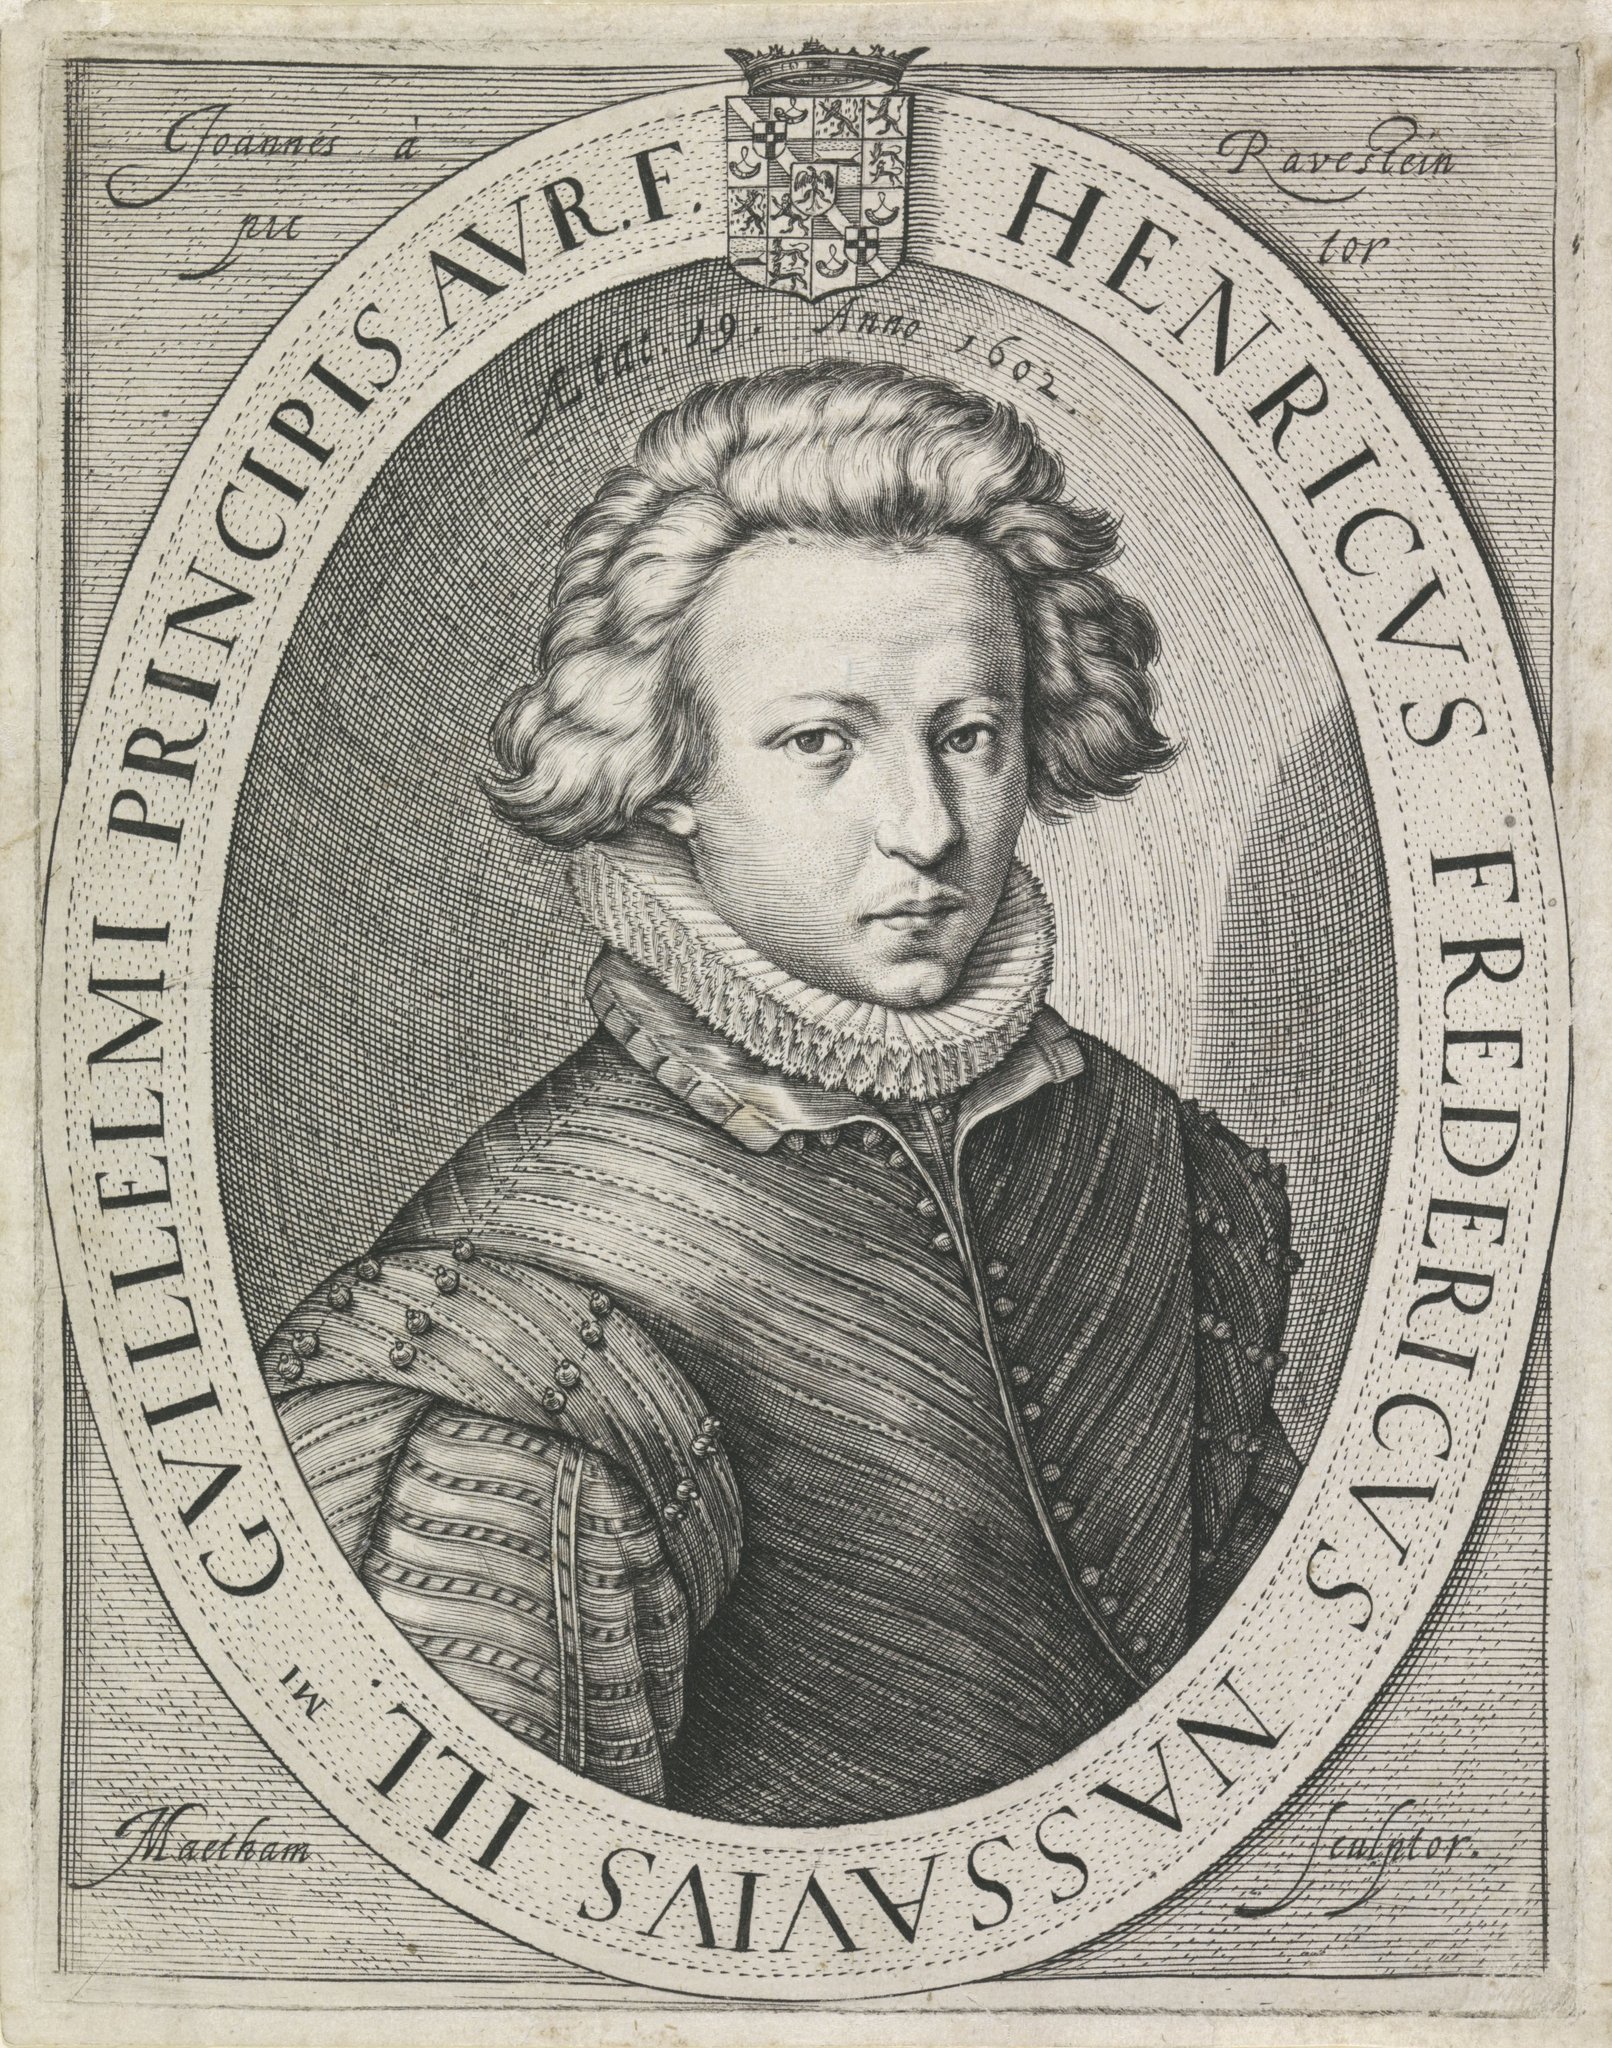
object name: print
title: Portret van Frederik Hendrik, prins van Oranje, op 19-jarige leeftijd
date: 1598-1631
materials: paper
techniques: engraving, etching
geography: haarlem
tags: delft, the hague, frederick henry (prince of orange)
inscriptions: collector's mark: Lugt 2228, collector's mark: Lugt 963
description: De hier vermelde titel verwijst naar de hoogst verkregen titel van de geportretteerde, niet per se naar de titel die de geportretteerde op deze voorstelling draagt.